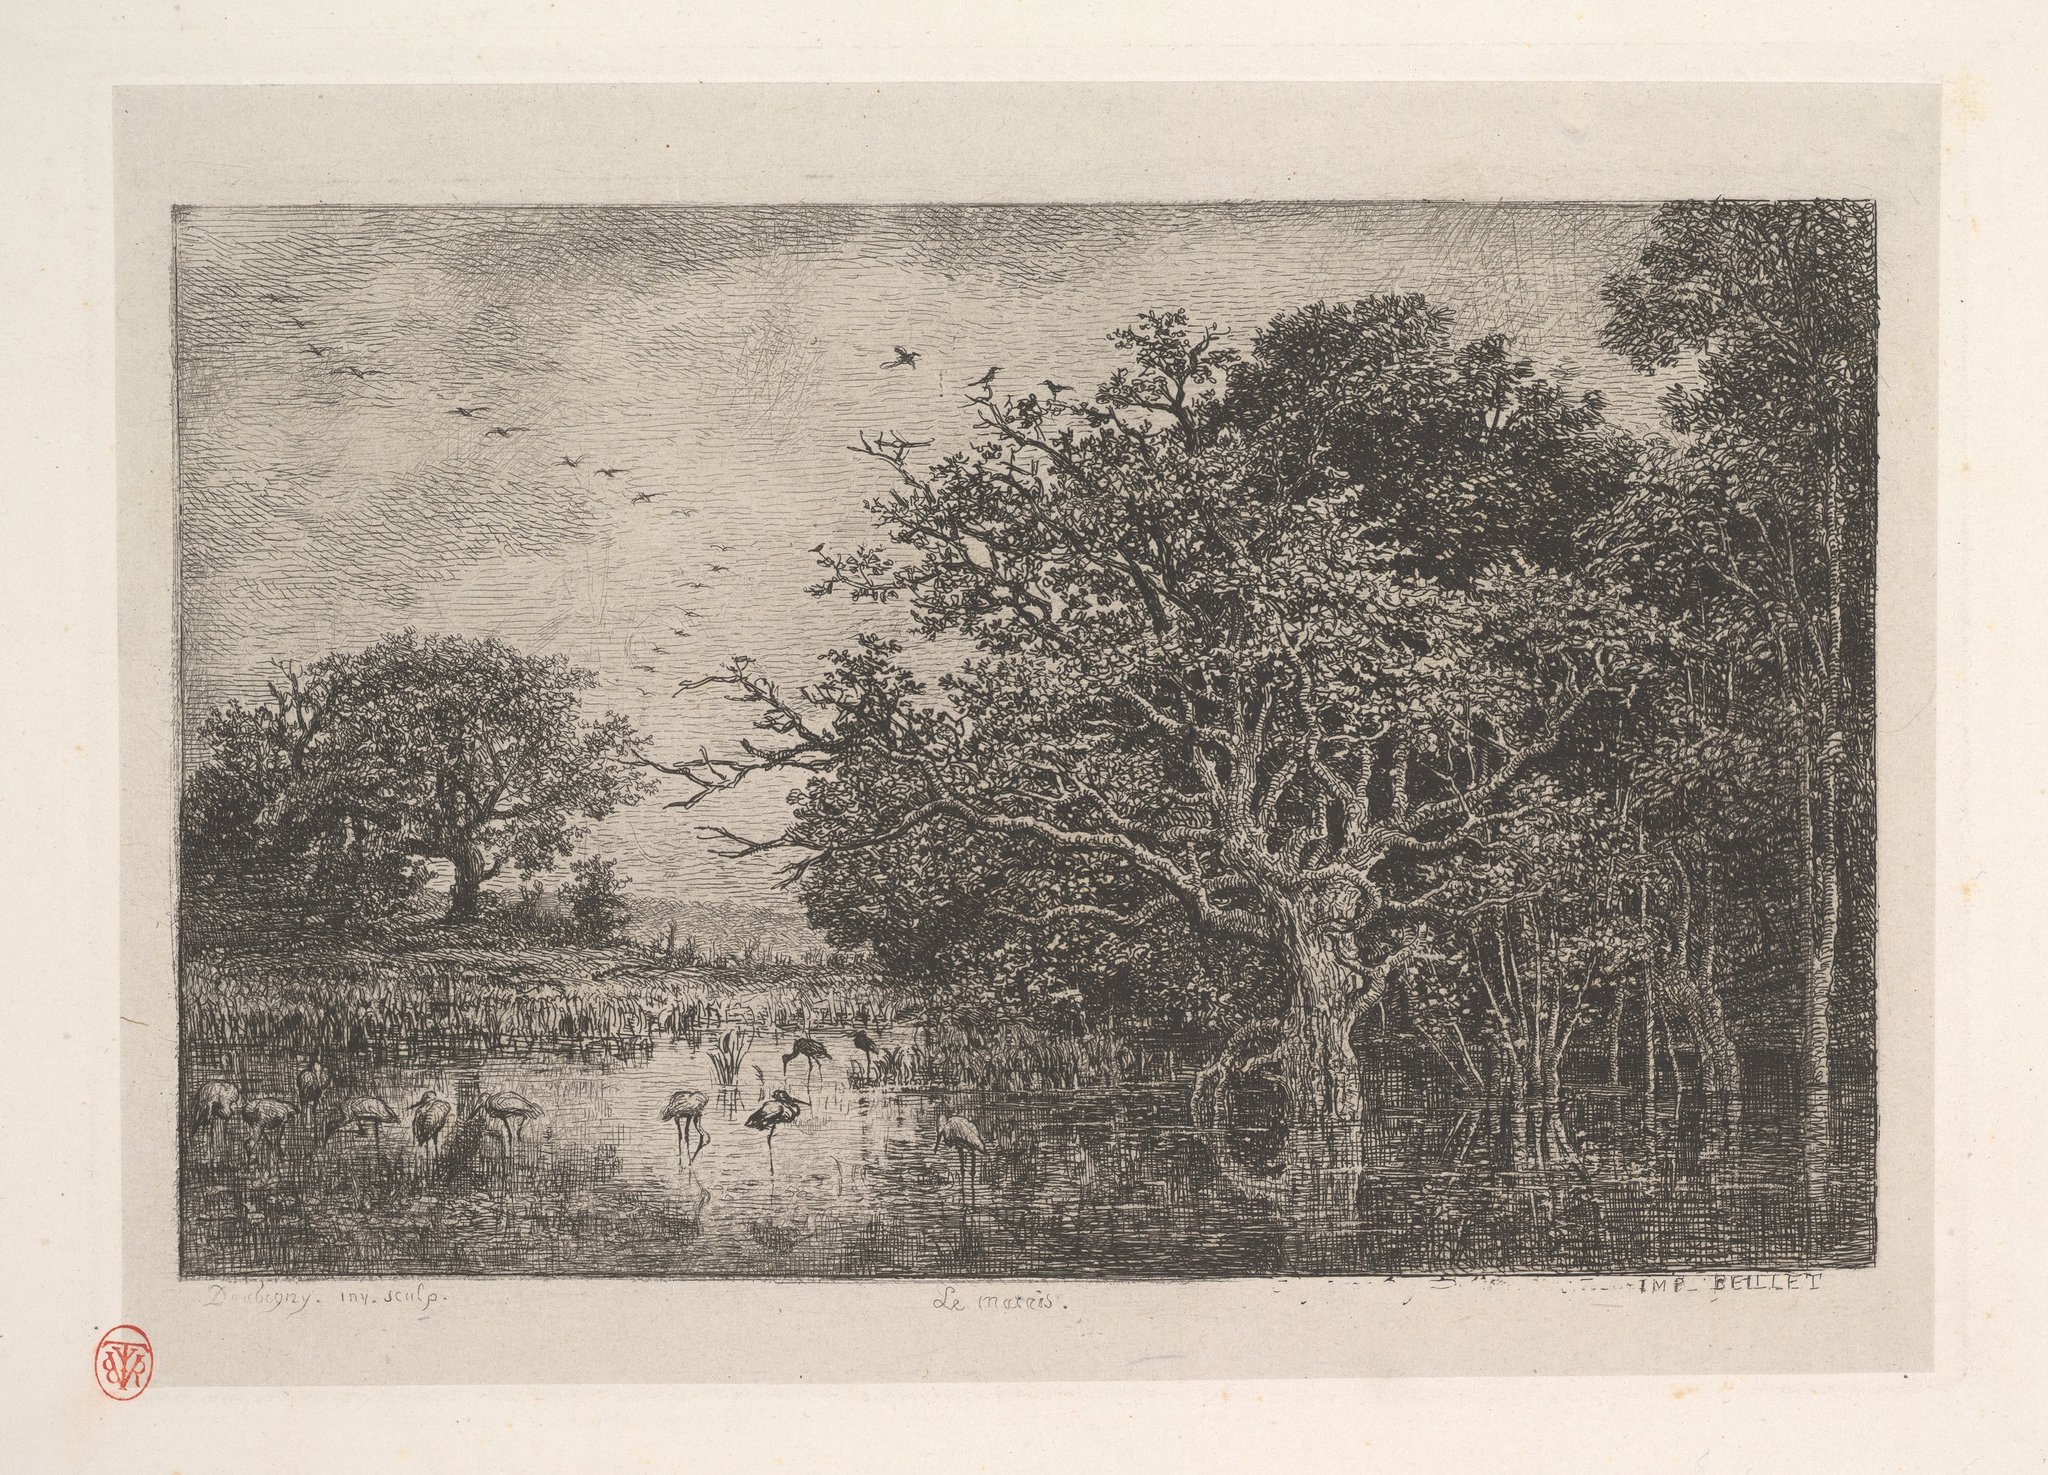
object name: print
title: The Marshes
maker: charles-françois daubigny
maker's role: artist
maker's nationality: french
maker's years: 1817-1878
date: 1851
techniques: printmaking, etching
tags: birds,landscapes,trees